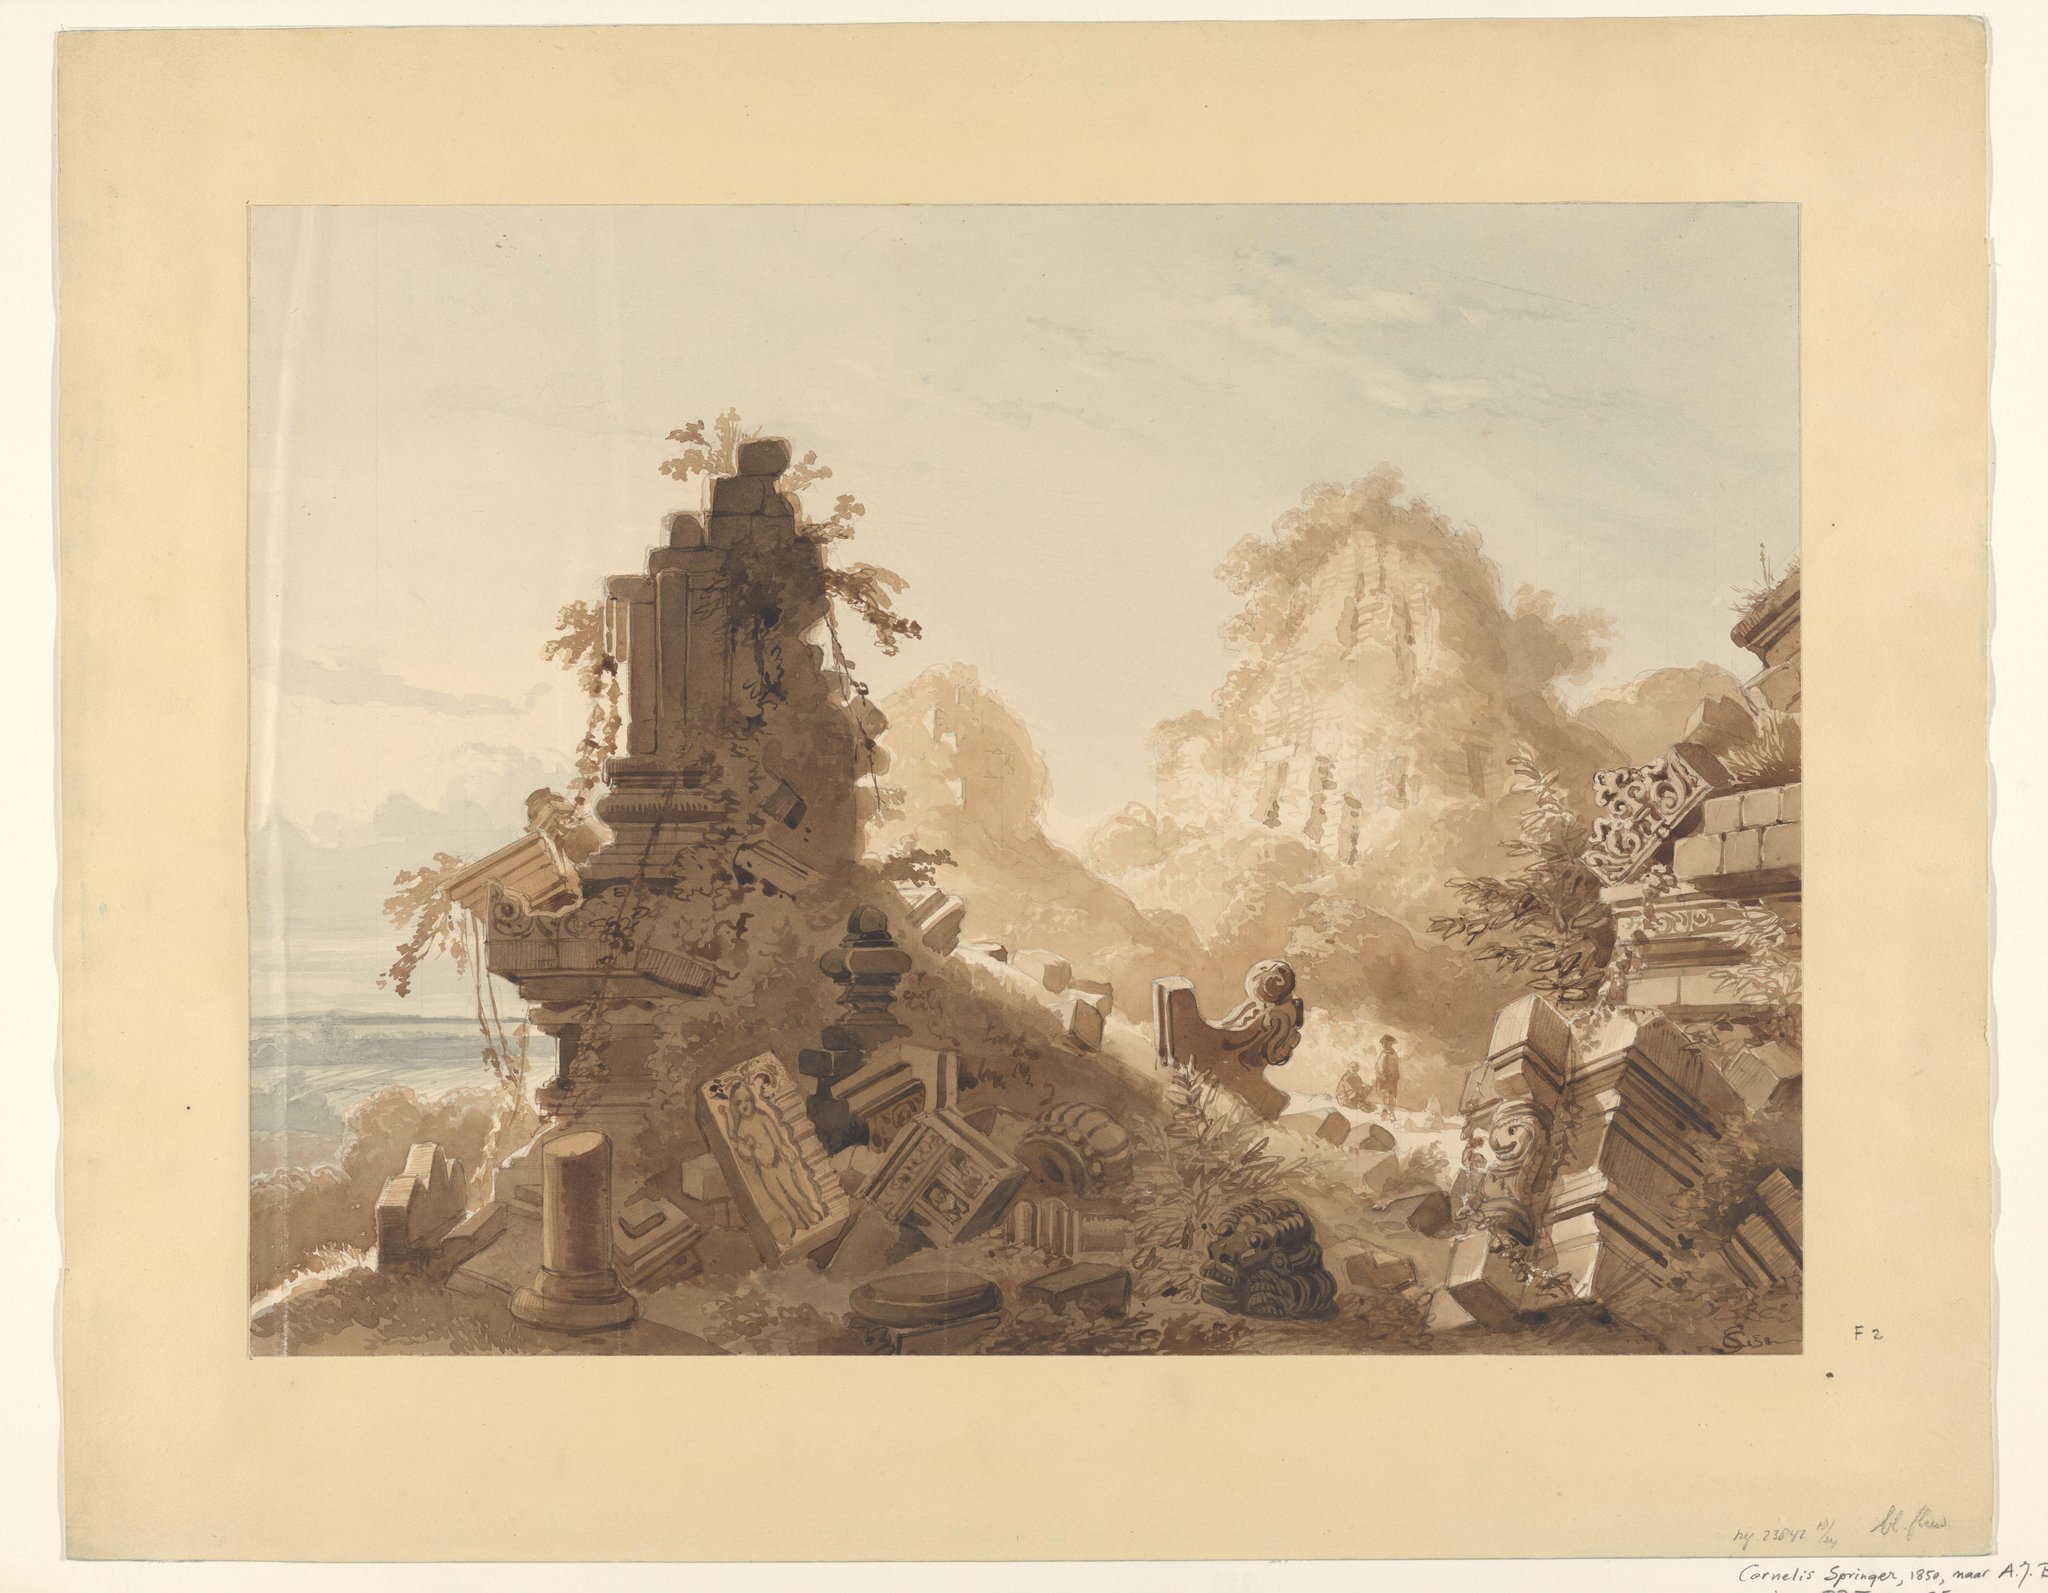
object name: drawing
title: Gezicht op de ruïne van Candi Lara Jonggrang (Prambanan) bij Yogyakarta, Midden-Java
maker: cornelis springer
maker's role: draughtsman, painter, print maker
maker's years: 1817-1891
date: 1850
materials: paper, pencil, watercolor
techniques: brush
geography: central java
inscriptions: monogram and date: ‘monogram CS 50’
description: Ontwerptekening voor boekillustratie. A.J. Bik was beschermer van E.A. Hardouin; artikel over deze collectie in Bulletin van het rijksmuseum 49 [ 2001], nr.4, pp. 342 e.v.